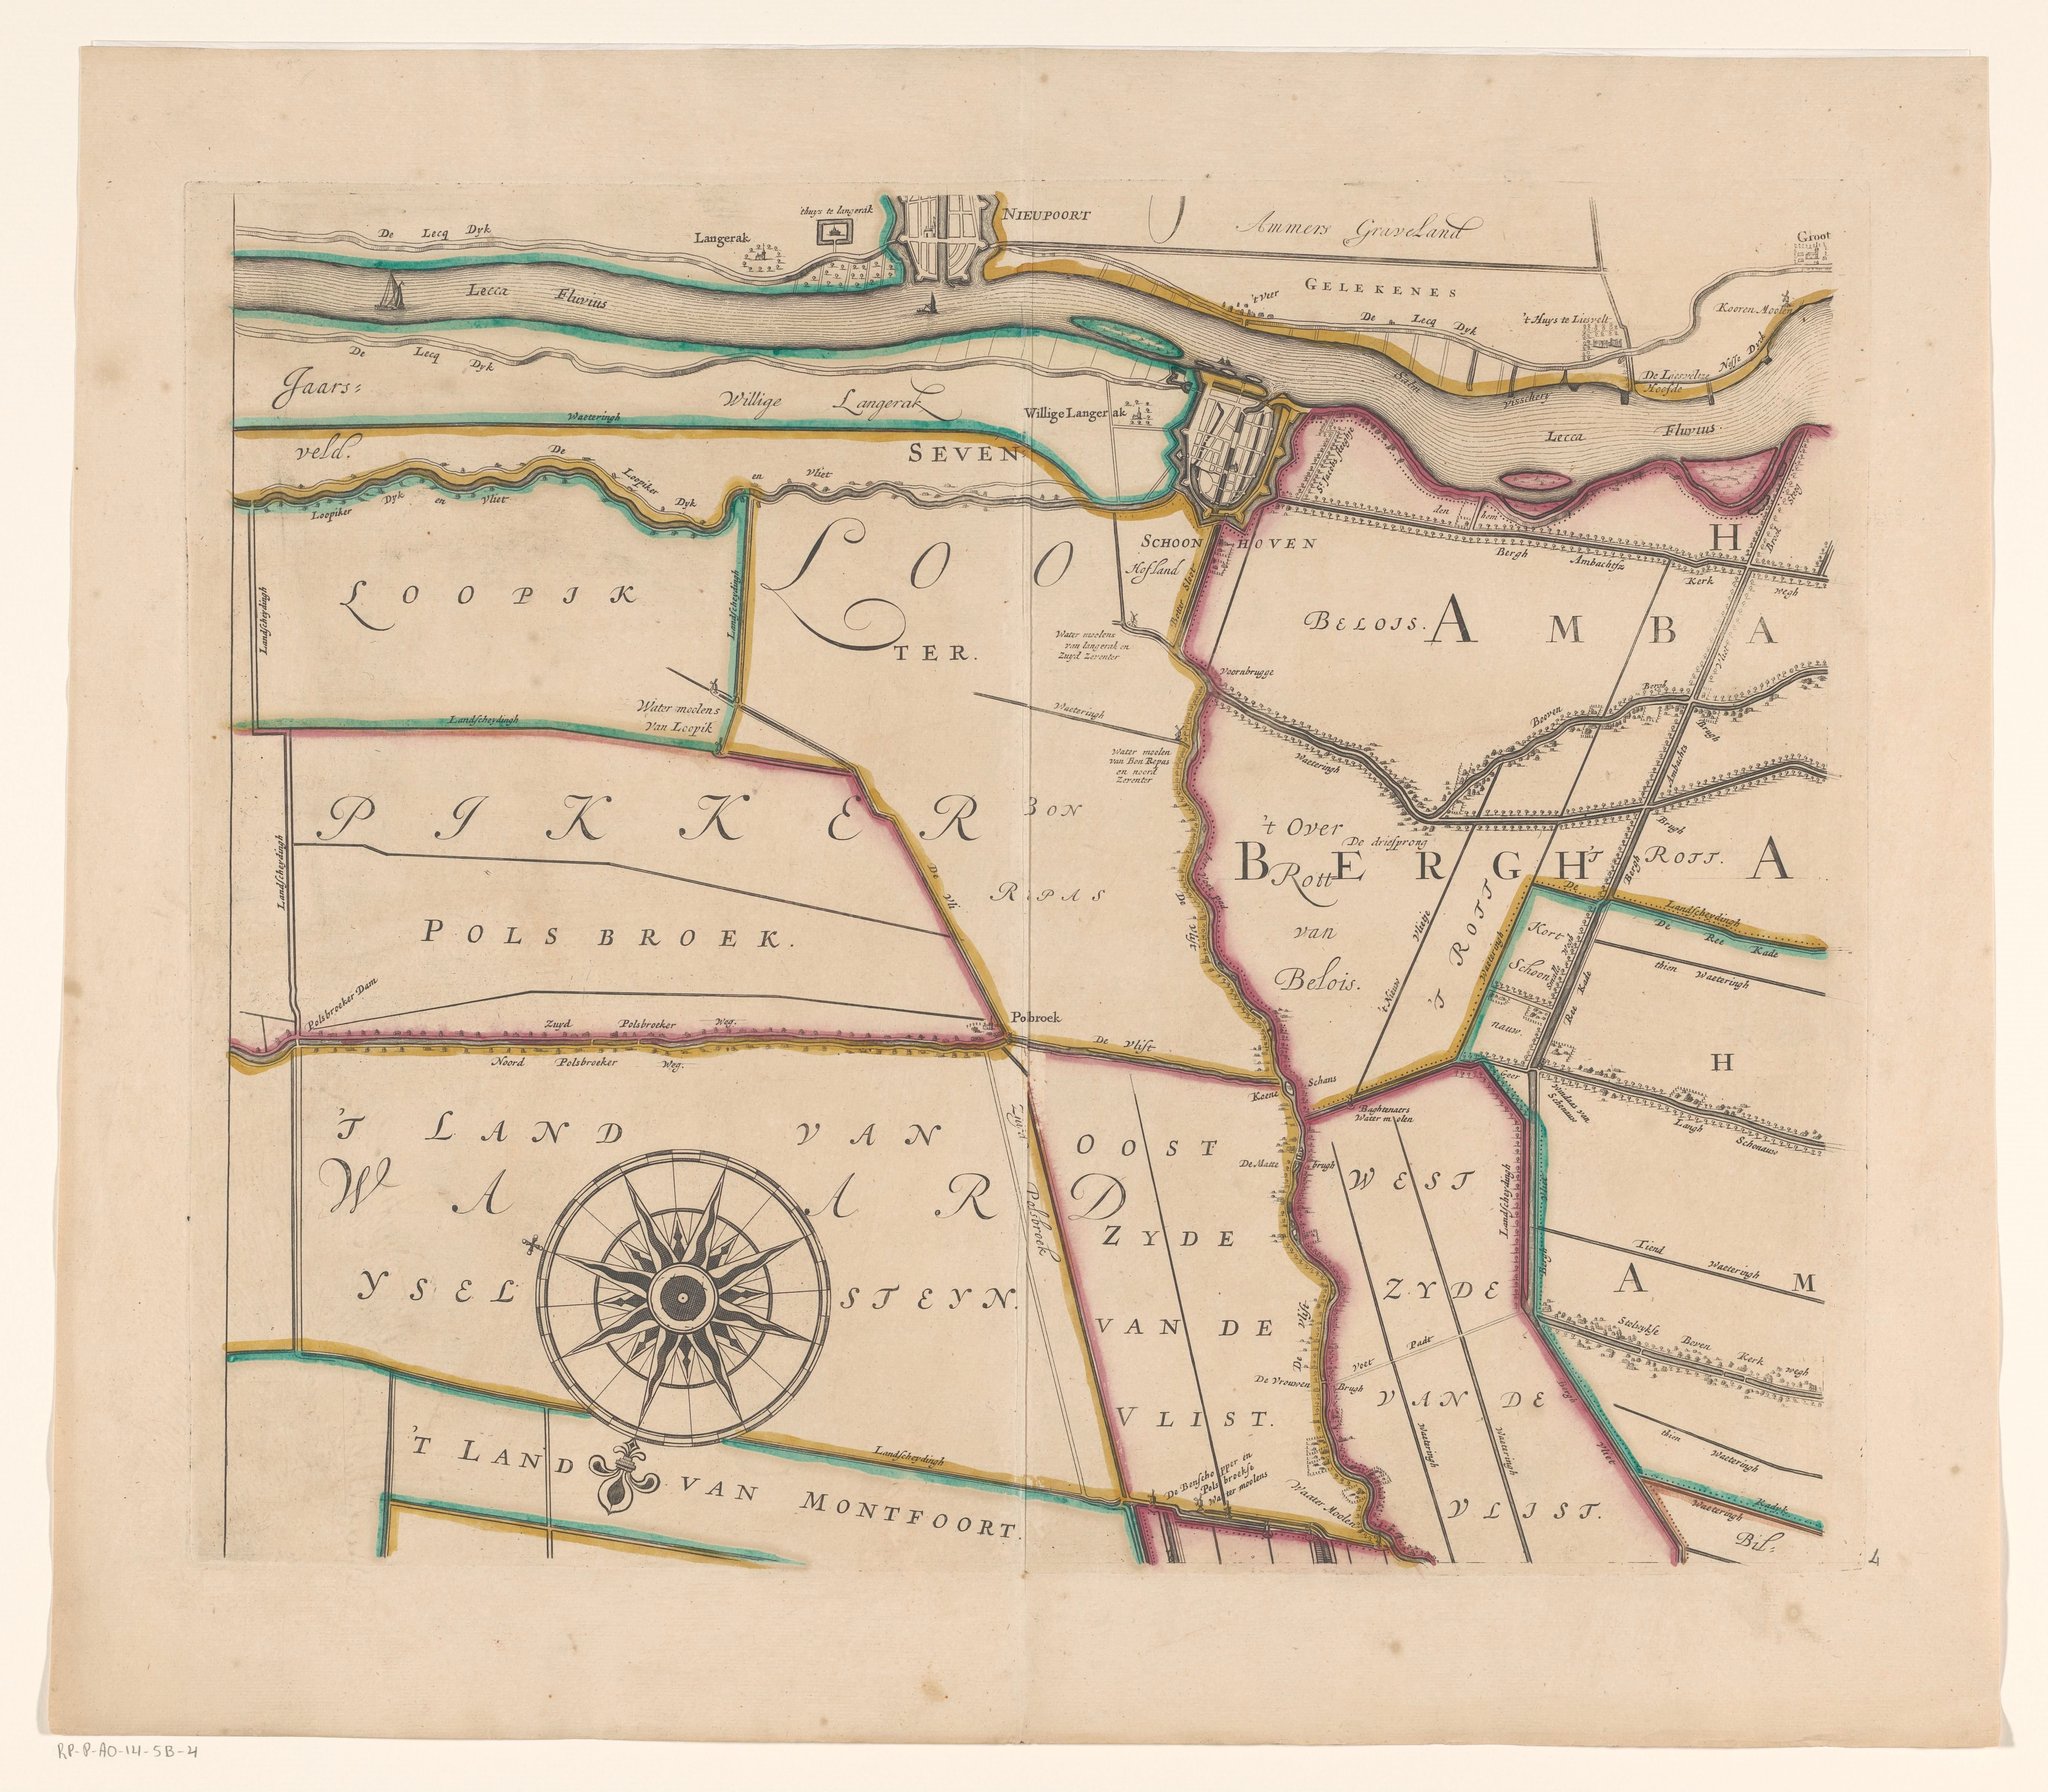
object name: print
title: Kaart van het Hoogheemraadschap van de Krimpenerwaard (eerste deel van kaart)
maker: johannes leupenius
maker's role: draughtsman, painter, print maker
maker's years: 1646-1693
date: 1683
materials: paper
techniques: engraving, etching, hand coloring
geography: amsterdam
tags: maps of separate countries or regions, maps of cities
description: Eerste deel van de kaart van de eerste druk van 'Het Hooge Heemraadschap vande Crimpenre Waard', een wandkaart (bestaande uit een zesdelige kaart en een wapenrand) van het Hoogheemraadschap van de Krimpenerwaard.